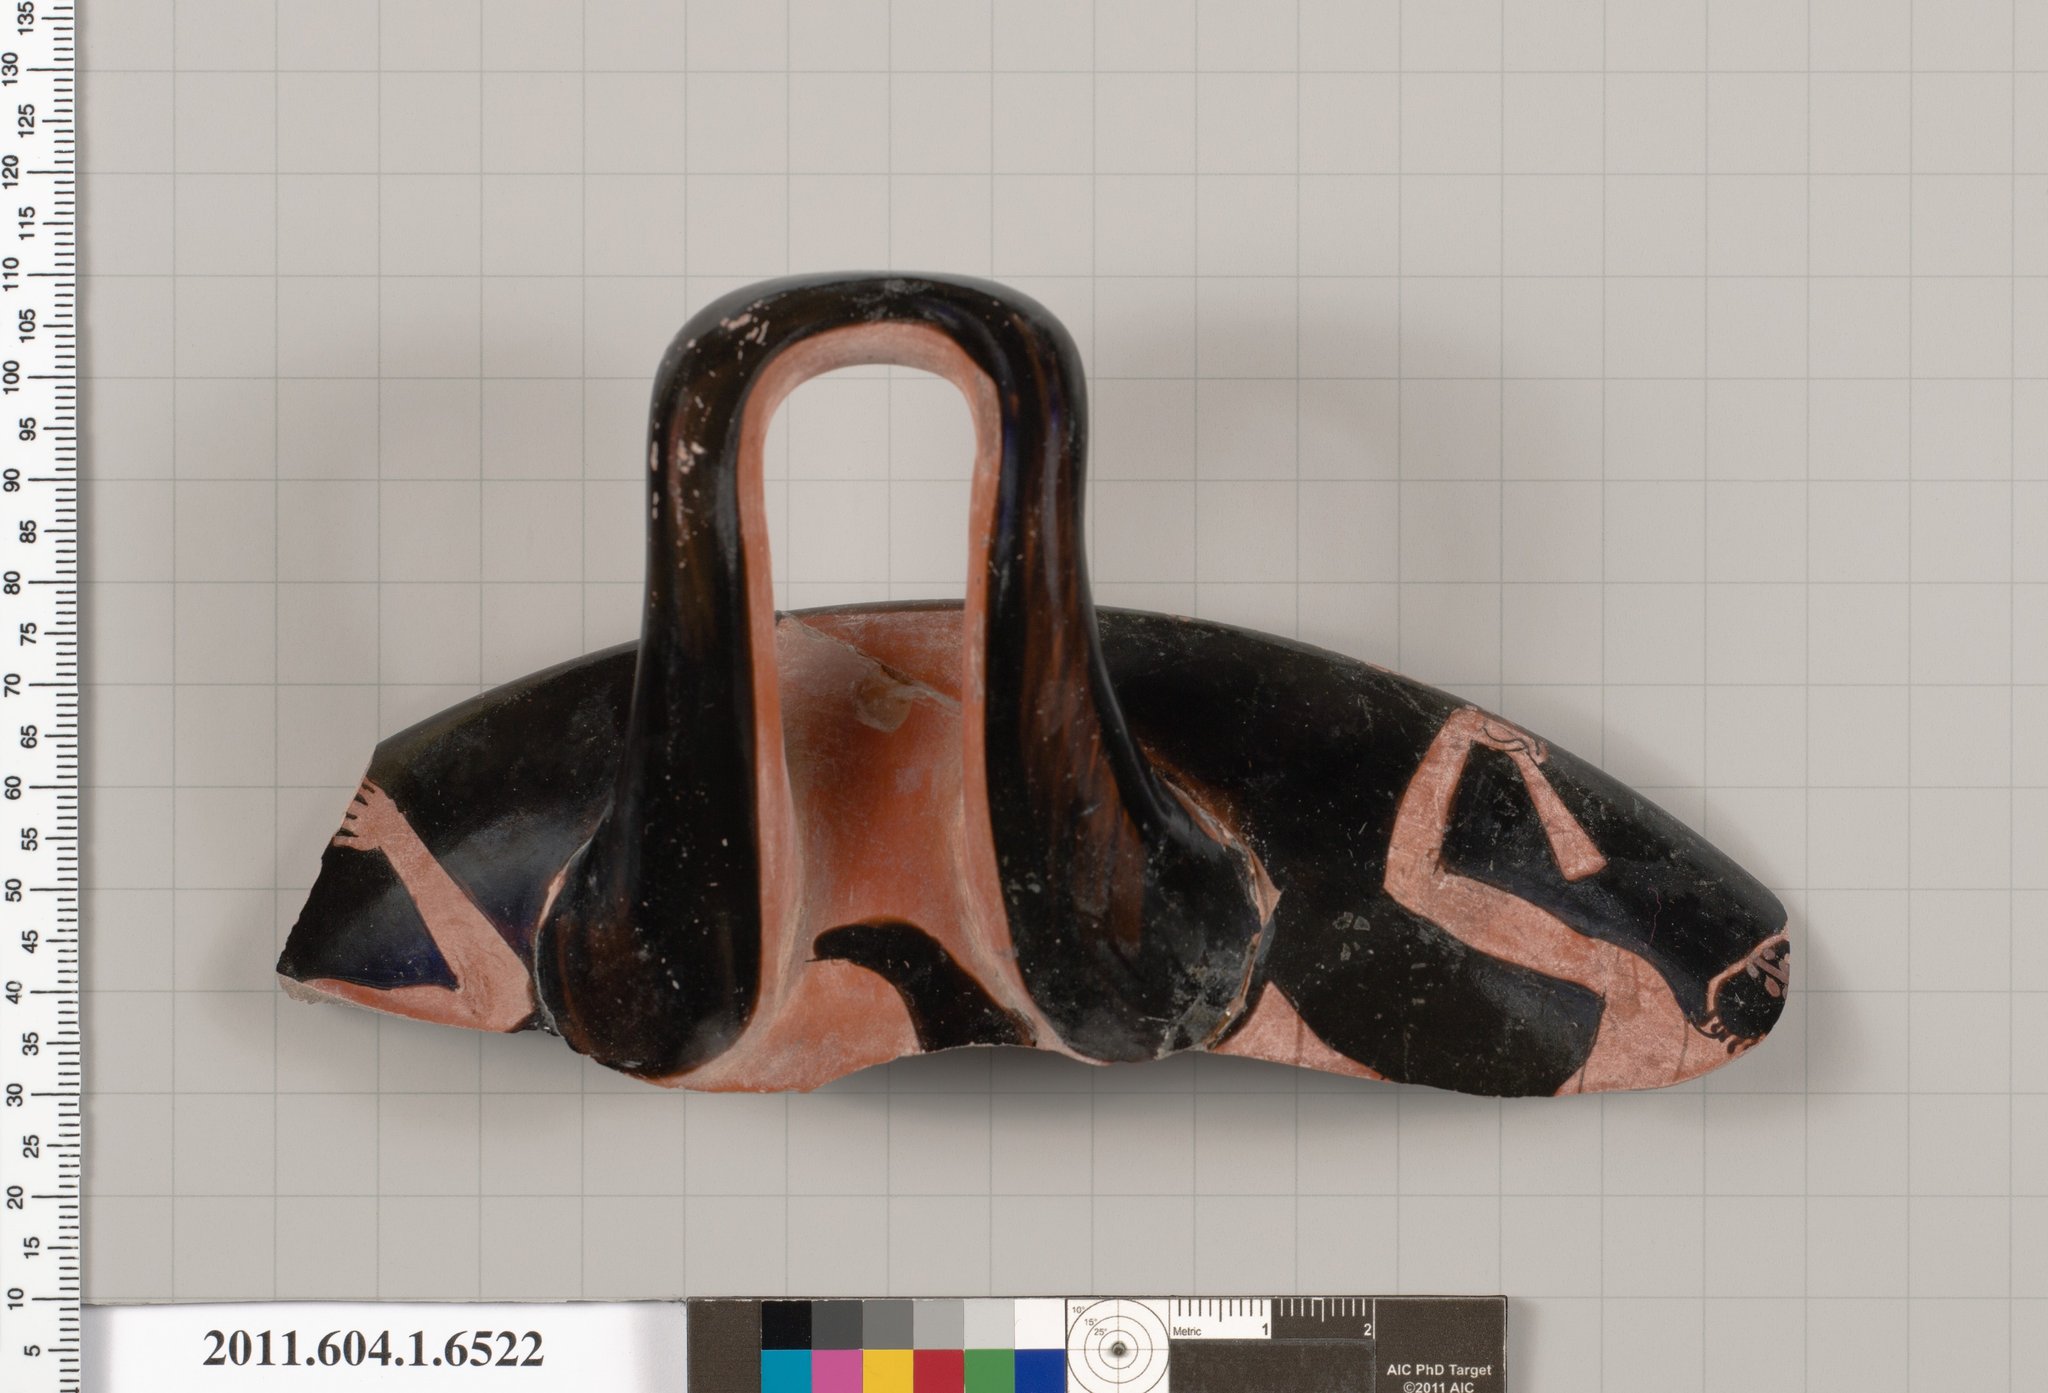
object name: kylix fragment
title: Terracotta rim fragment of a kylix (drinking cup)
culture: greek, attic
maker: colmar painter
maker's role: artist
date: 490-480 BCE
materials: terracotta